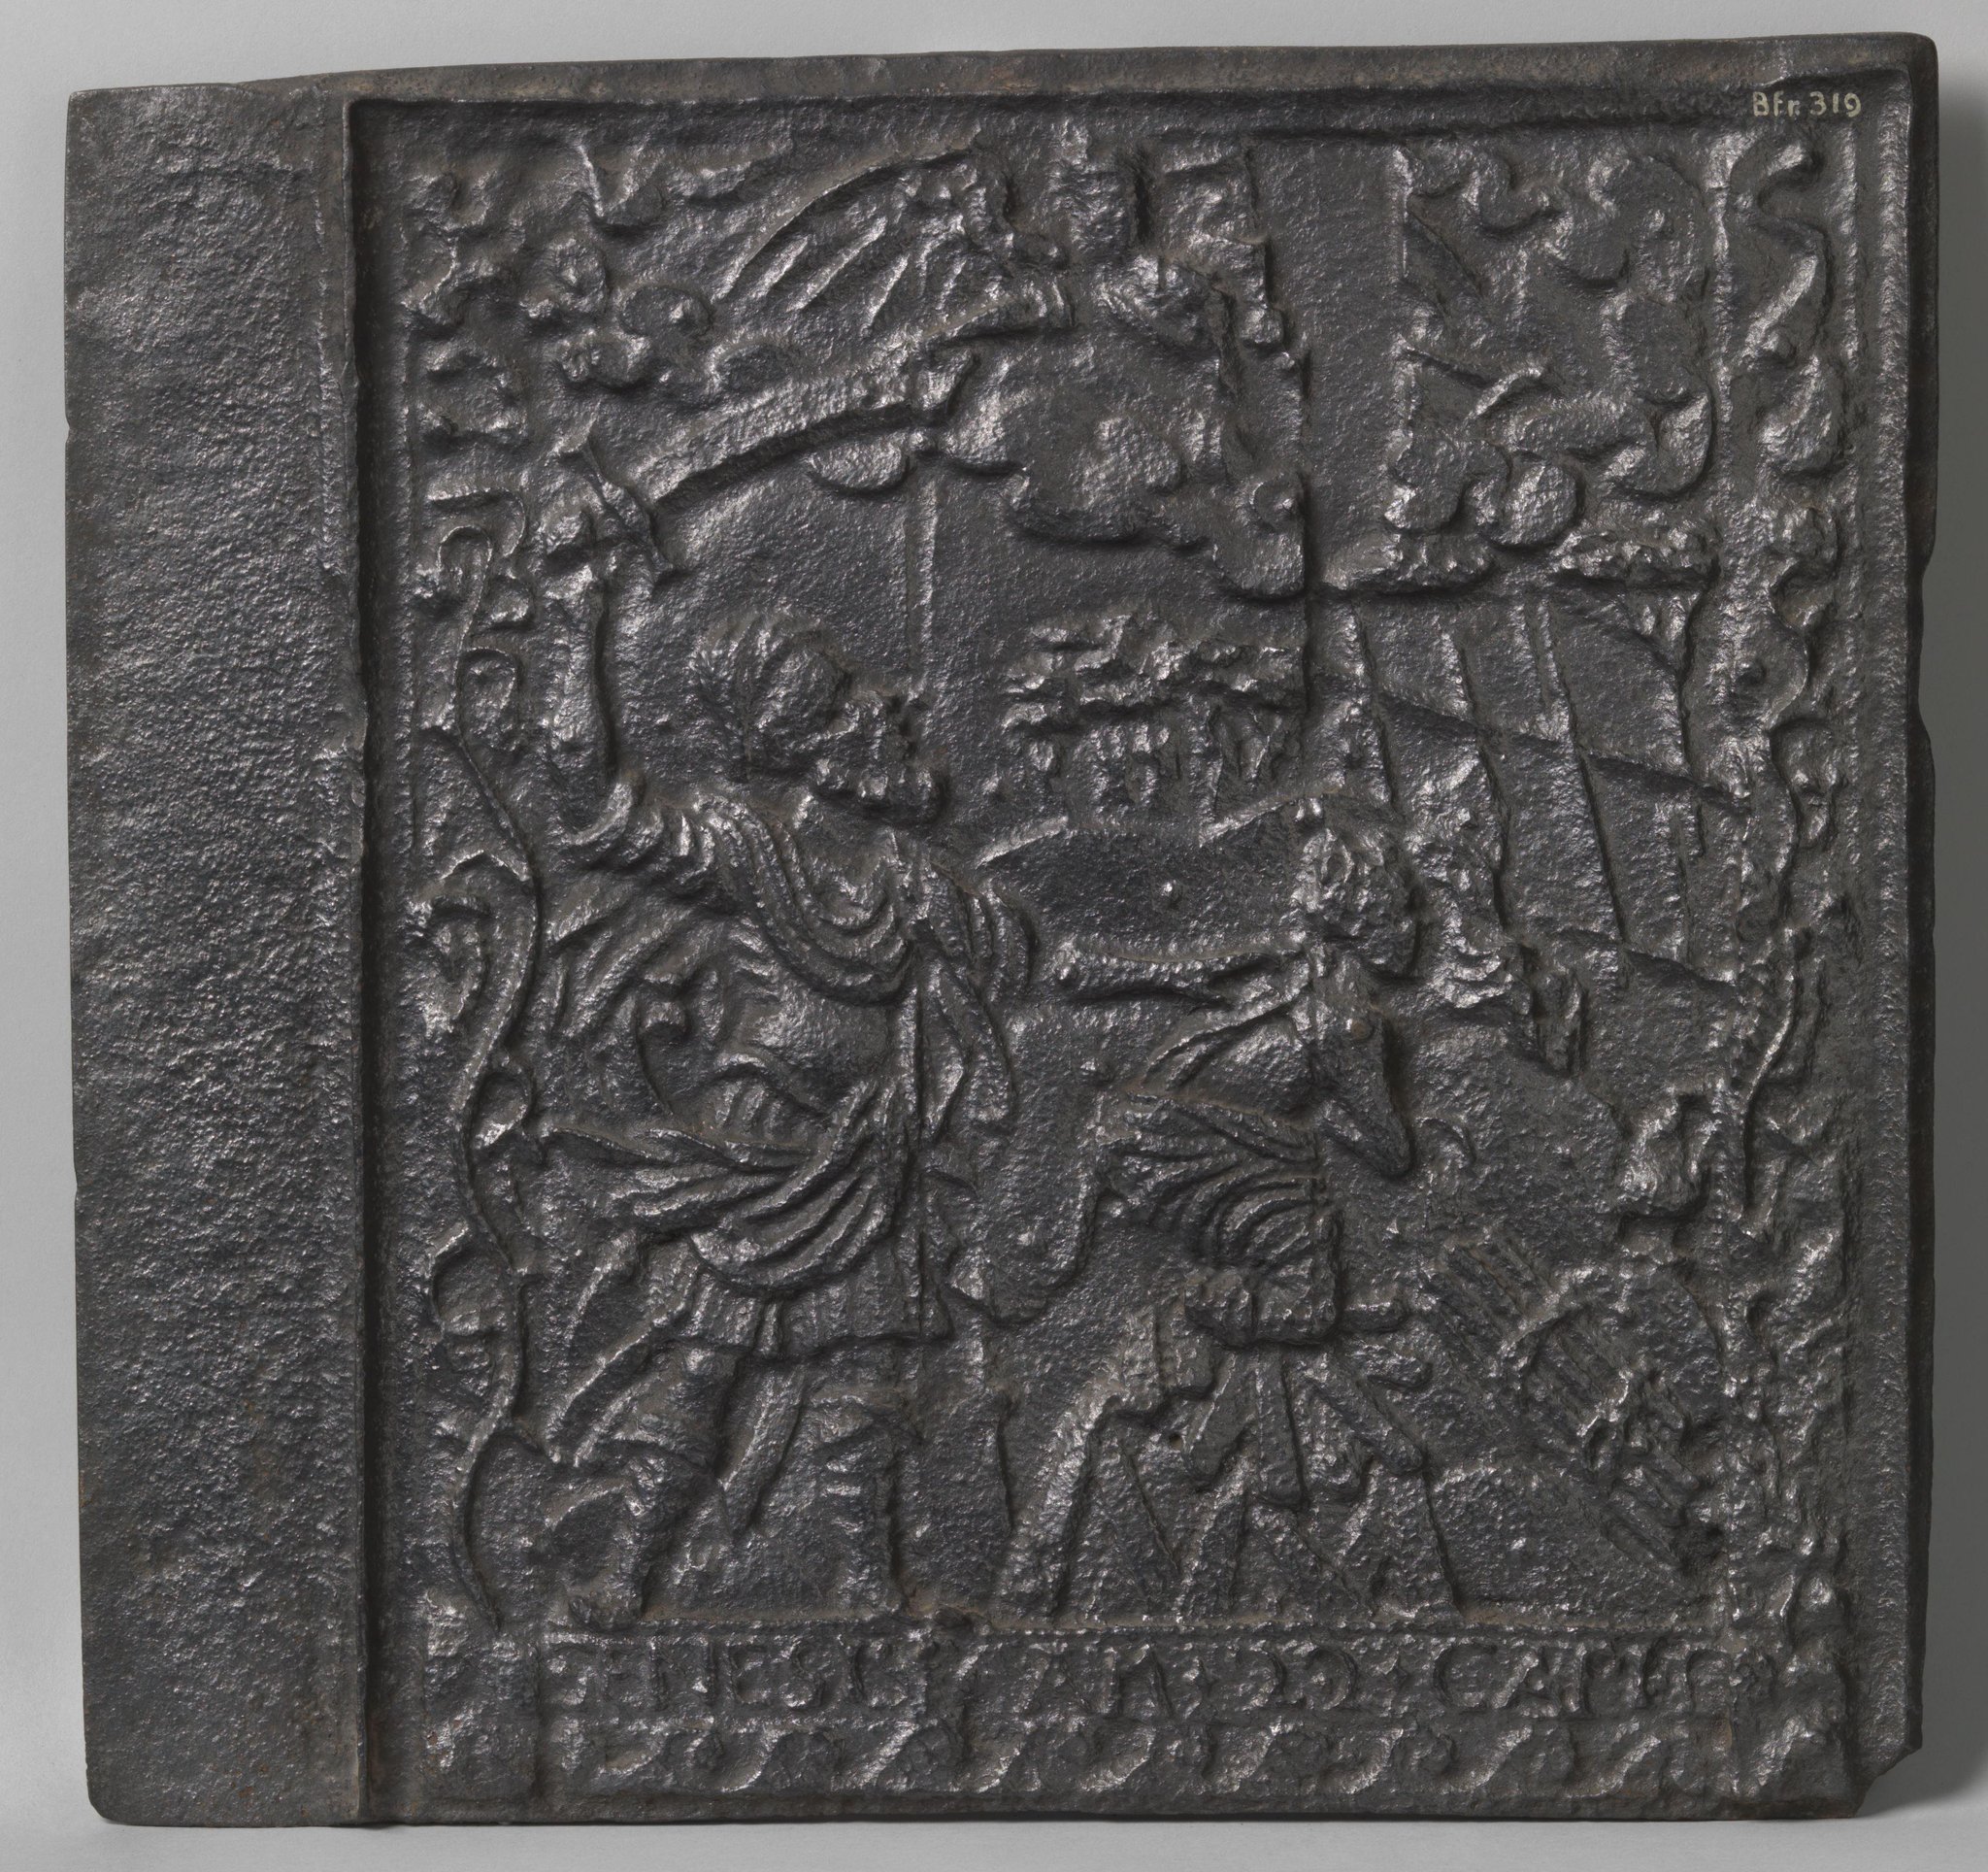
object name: stove plate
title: Kachelplaat met het offer van Abraham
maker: Anonymous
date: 1550-1600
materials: iron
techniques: casting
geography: germany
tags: the sacrifice of isaac (genesis 22)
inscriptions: inscription: ‘GENESIS.AM.22.CAPIT’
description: Kachelplaat van gietijzer, verdeeld in twee zones. In de bovenste zone is het offer van Abraham verbeeld, met links met geheven zwaard Abraham. Rechts naast hem knielt Isaak op een stapel hout. Voor hem ligt nog een bundel hout. Geheel bovenaan vliegt een engel, die het zwaard tegenhoudt. Onder de voorstelling een tekstband. De onderste zone is verloren gegaan. Het model van de bovenste zone is beschadigd geraakt, waardoor het middendeel van het lichaam van de engel niet is afgebeeld. Boven het hoofd van Isaak is een raster te zien, waar oorspronkelijk een ram was bedoeld.